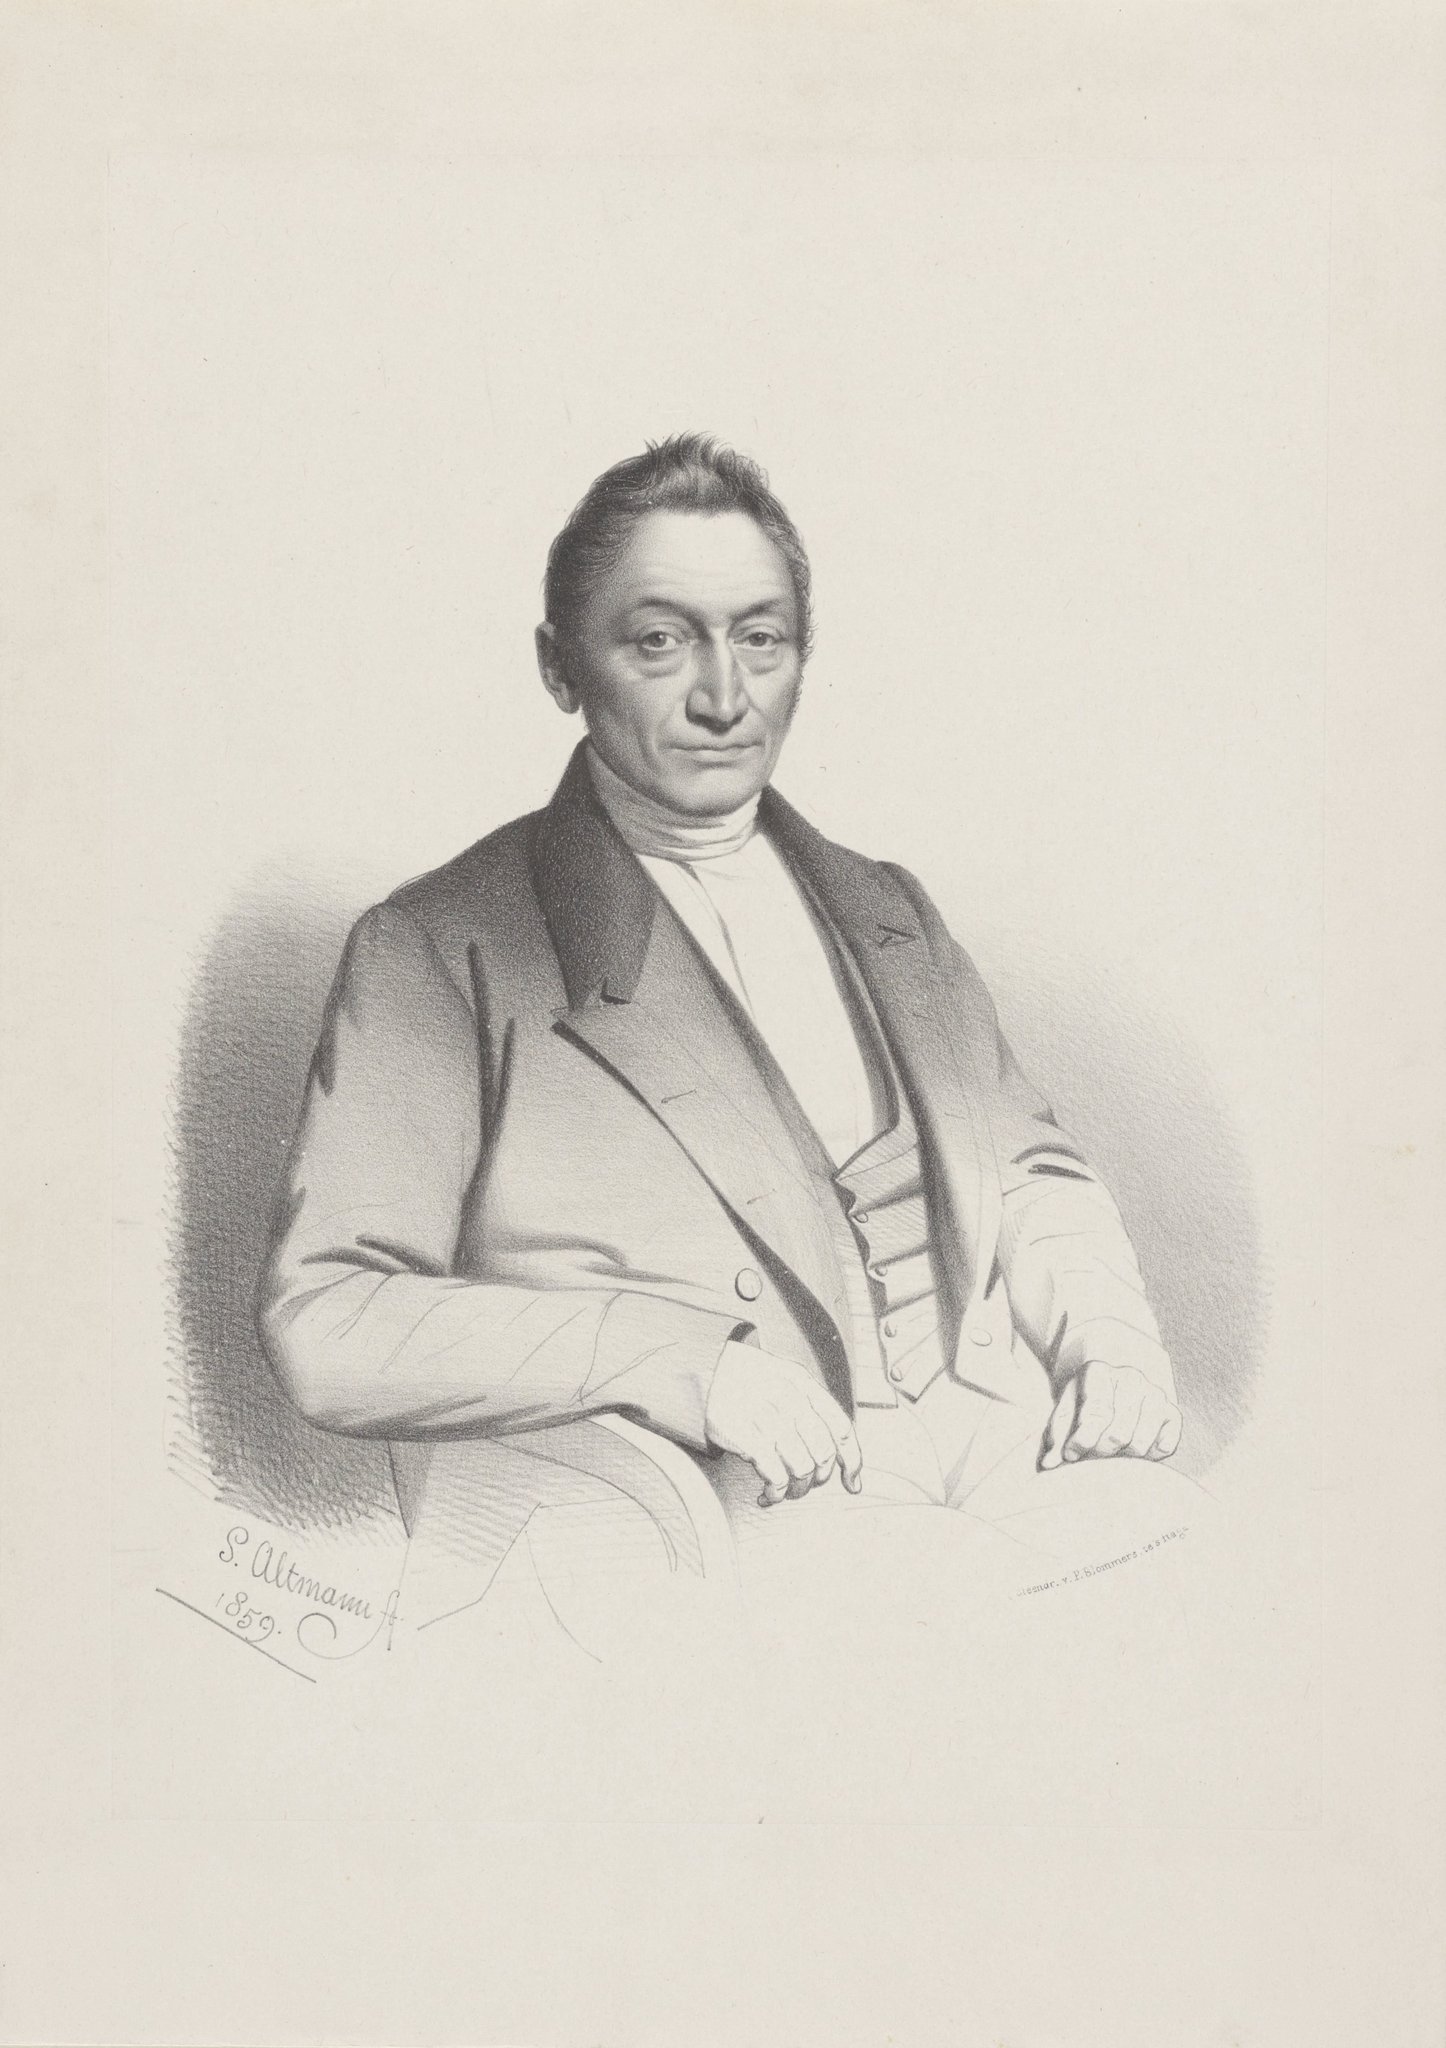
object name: print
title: Portret van predikant Herman Gerrit Jacobus van Doesburgh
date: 1842-1887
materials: paper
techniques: lithograph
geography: the hague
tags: rotterdam, historical persons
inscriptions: collector's mark: Lugt 2228